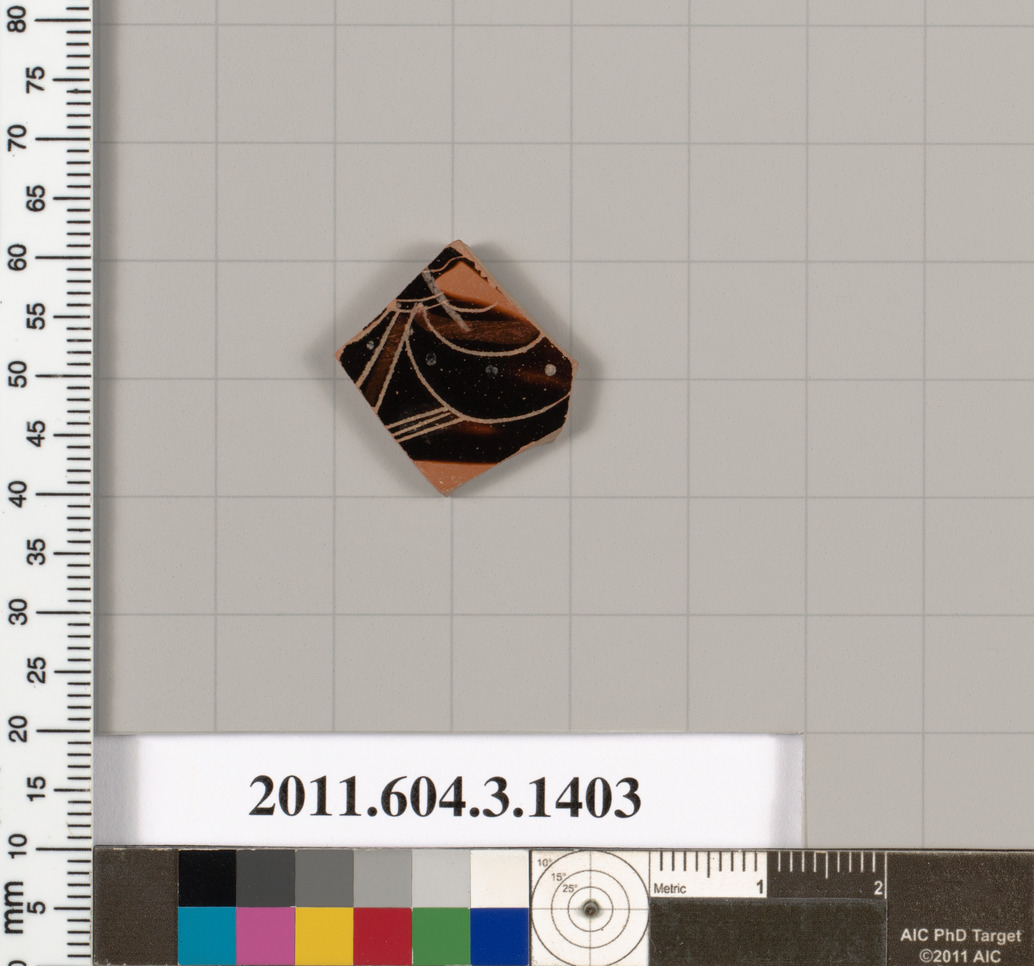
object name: skyphos fragment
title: Terracotta fragment of a skyphos (deep drinking cup)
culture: greek, attic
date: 534-468 BCE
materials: terracotta